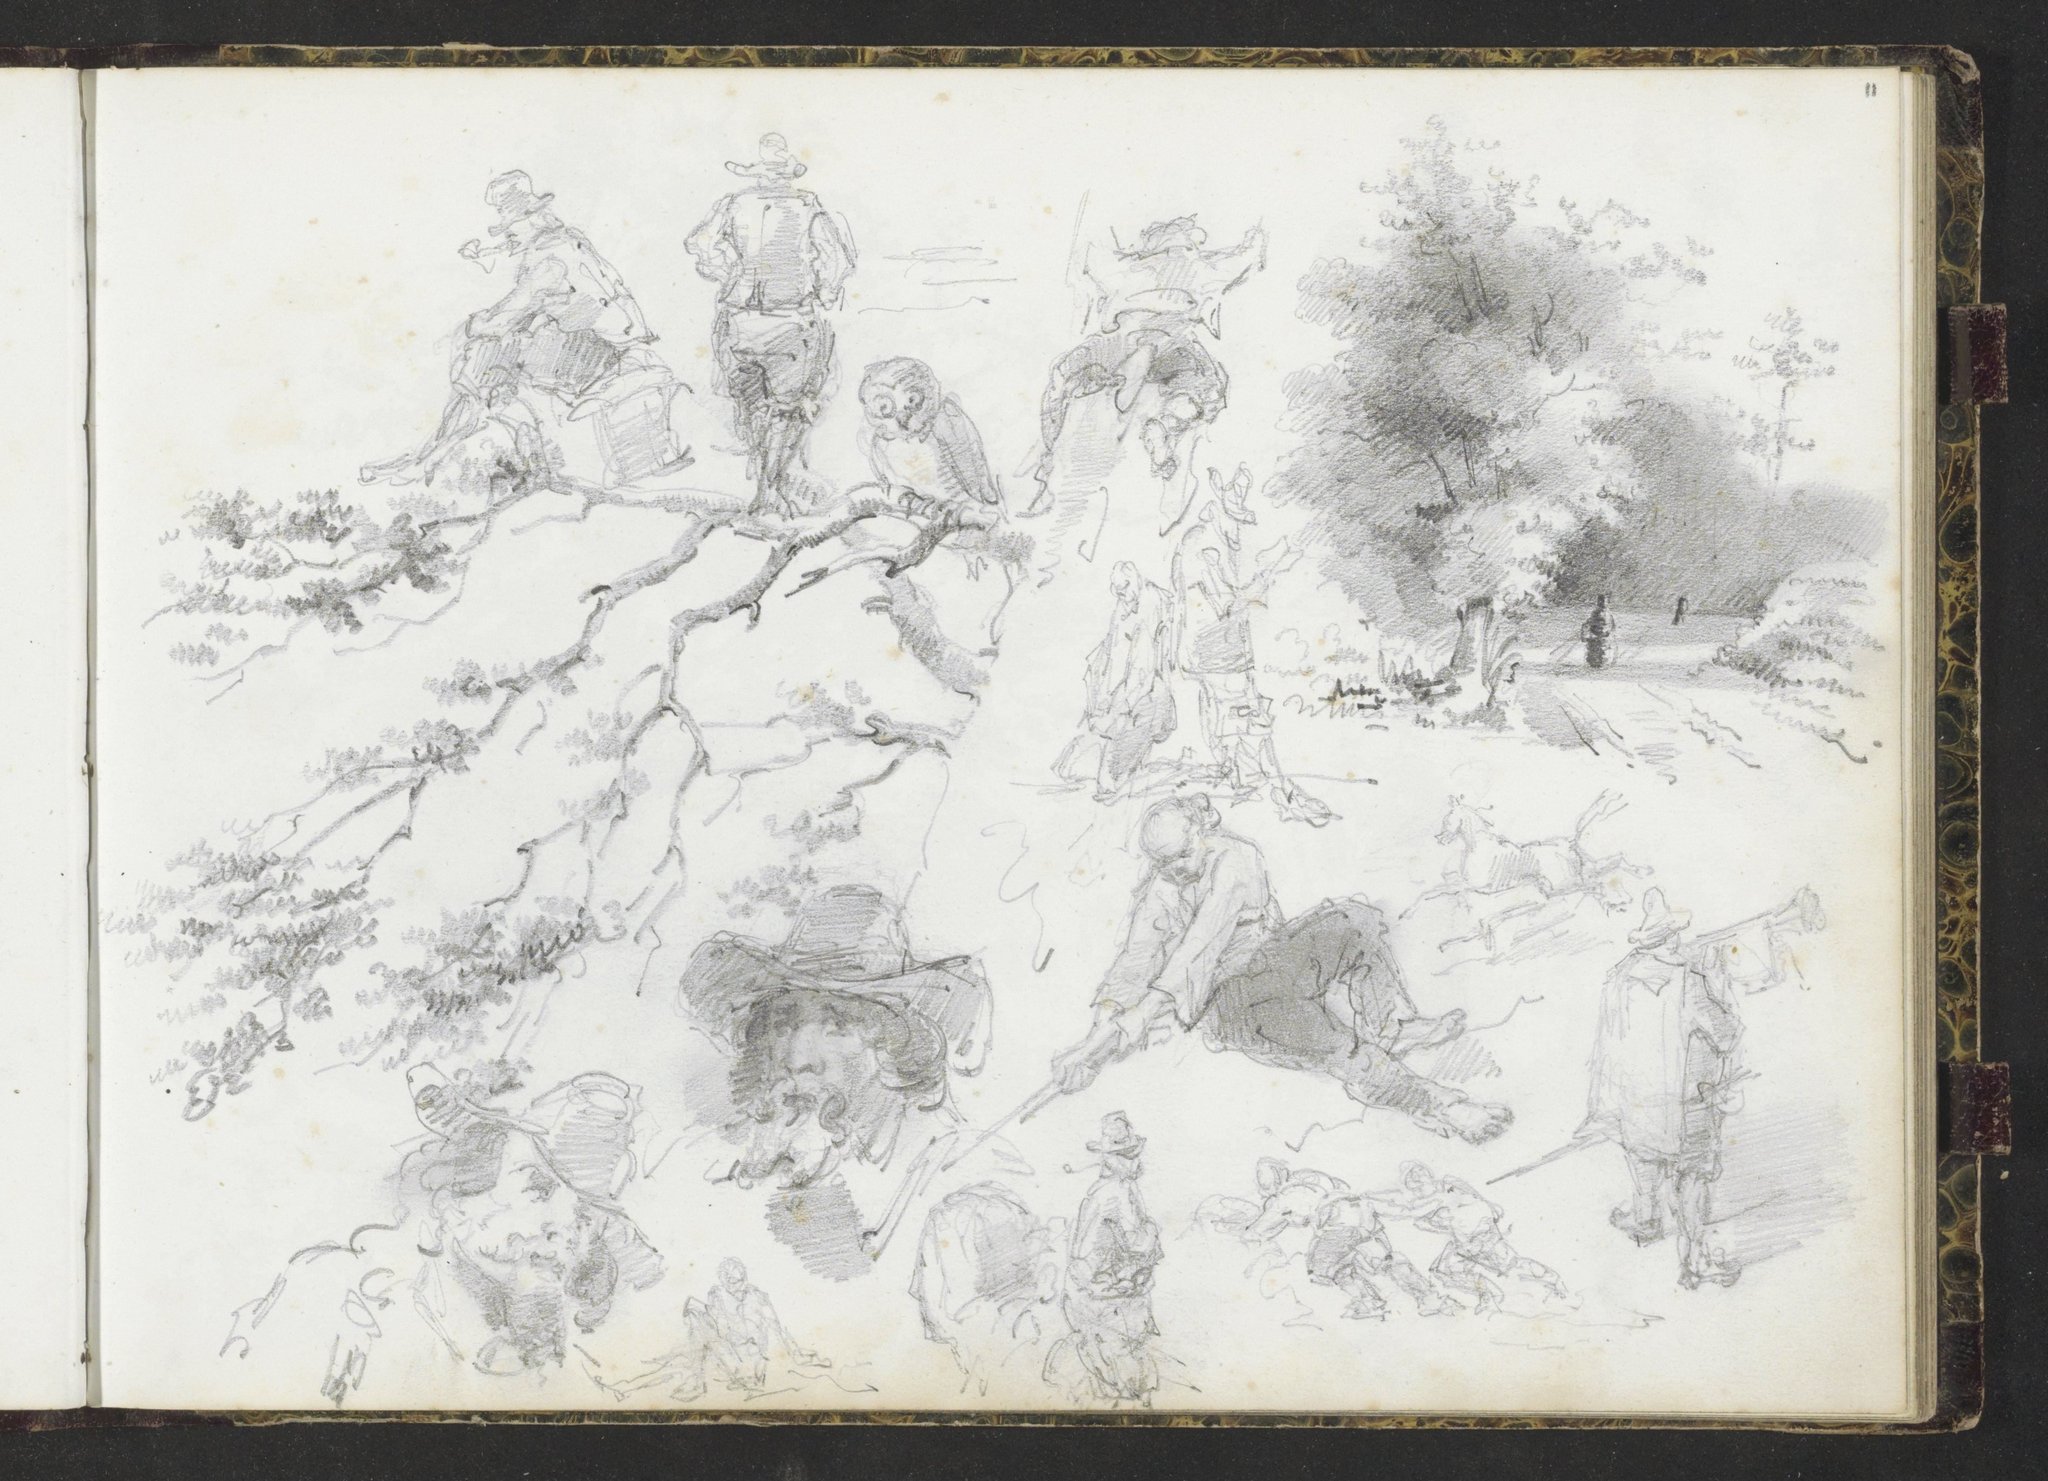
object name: sketchbook leaf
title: Studieblad met arbeiders, koppen, dieren en een bosgezicht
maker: lambertus lingeman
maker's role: draughtsman, painter, print maker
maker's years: 1829-1894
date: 1839-1894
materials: paper, pencil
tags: head (human), trees (+ branch, stick), working class, labourers, forest, wood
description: Blad 11 recto uit een schetsboek met 51 bladen.